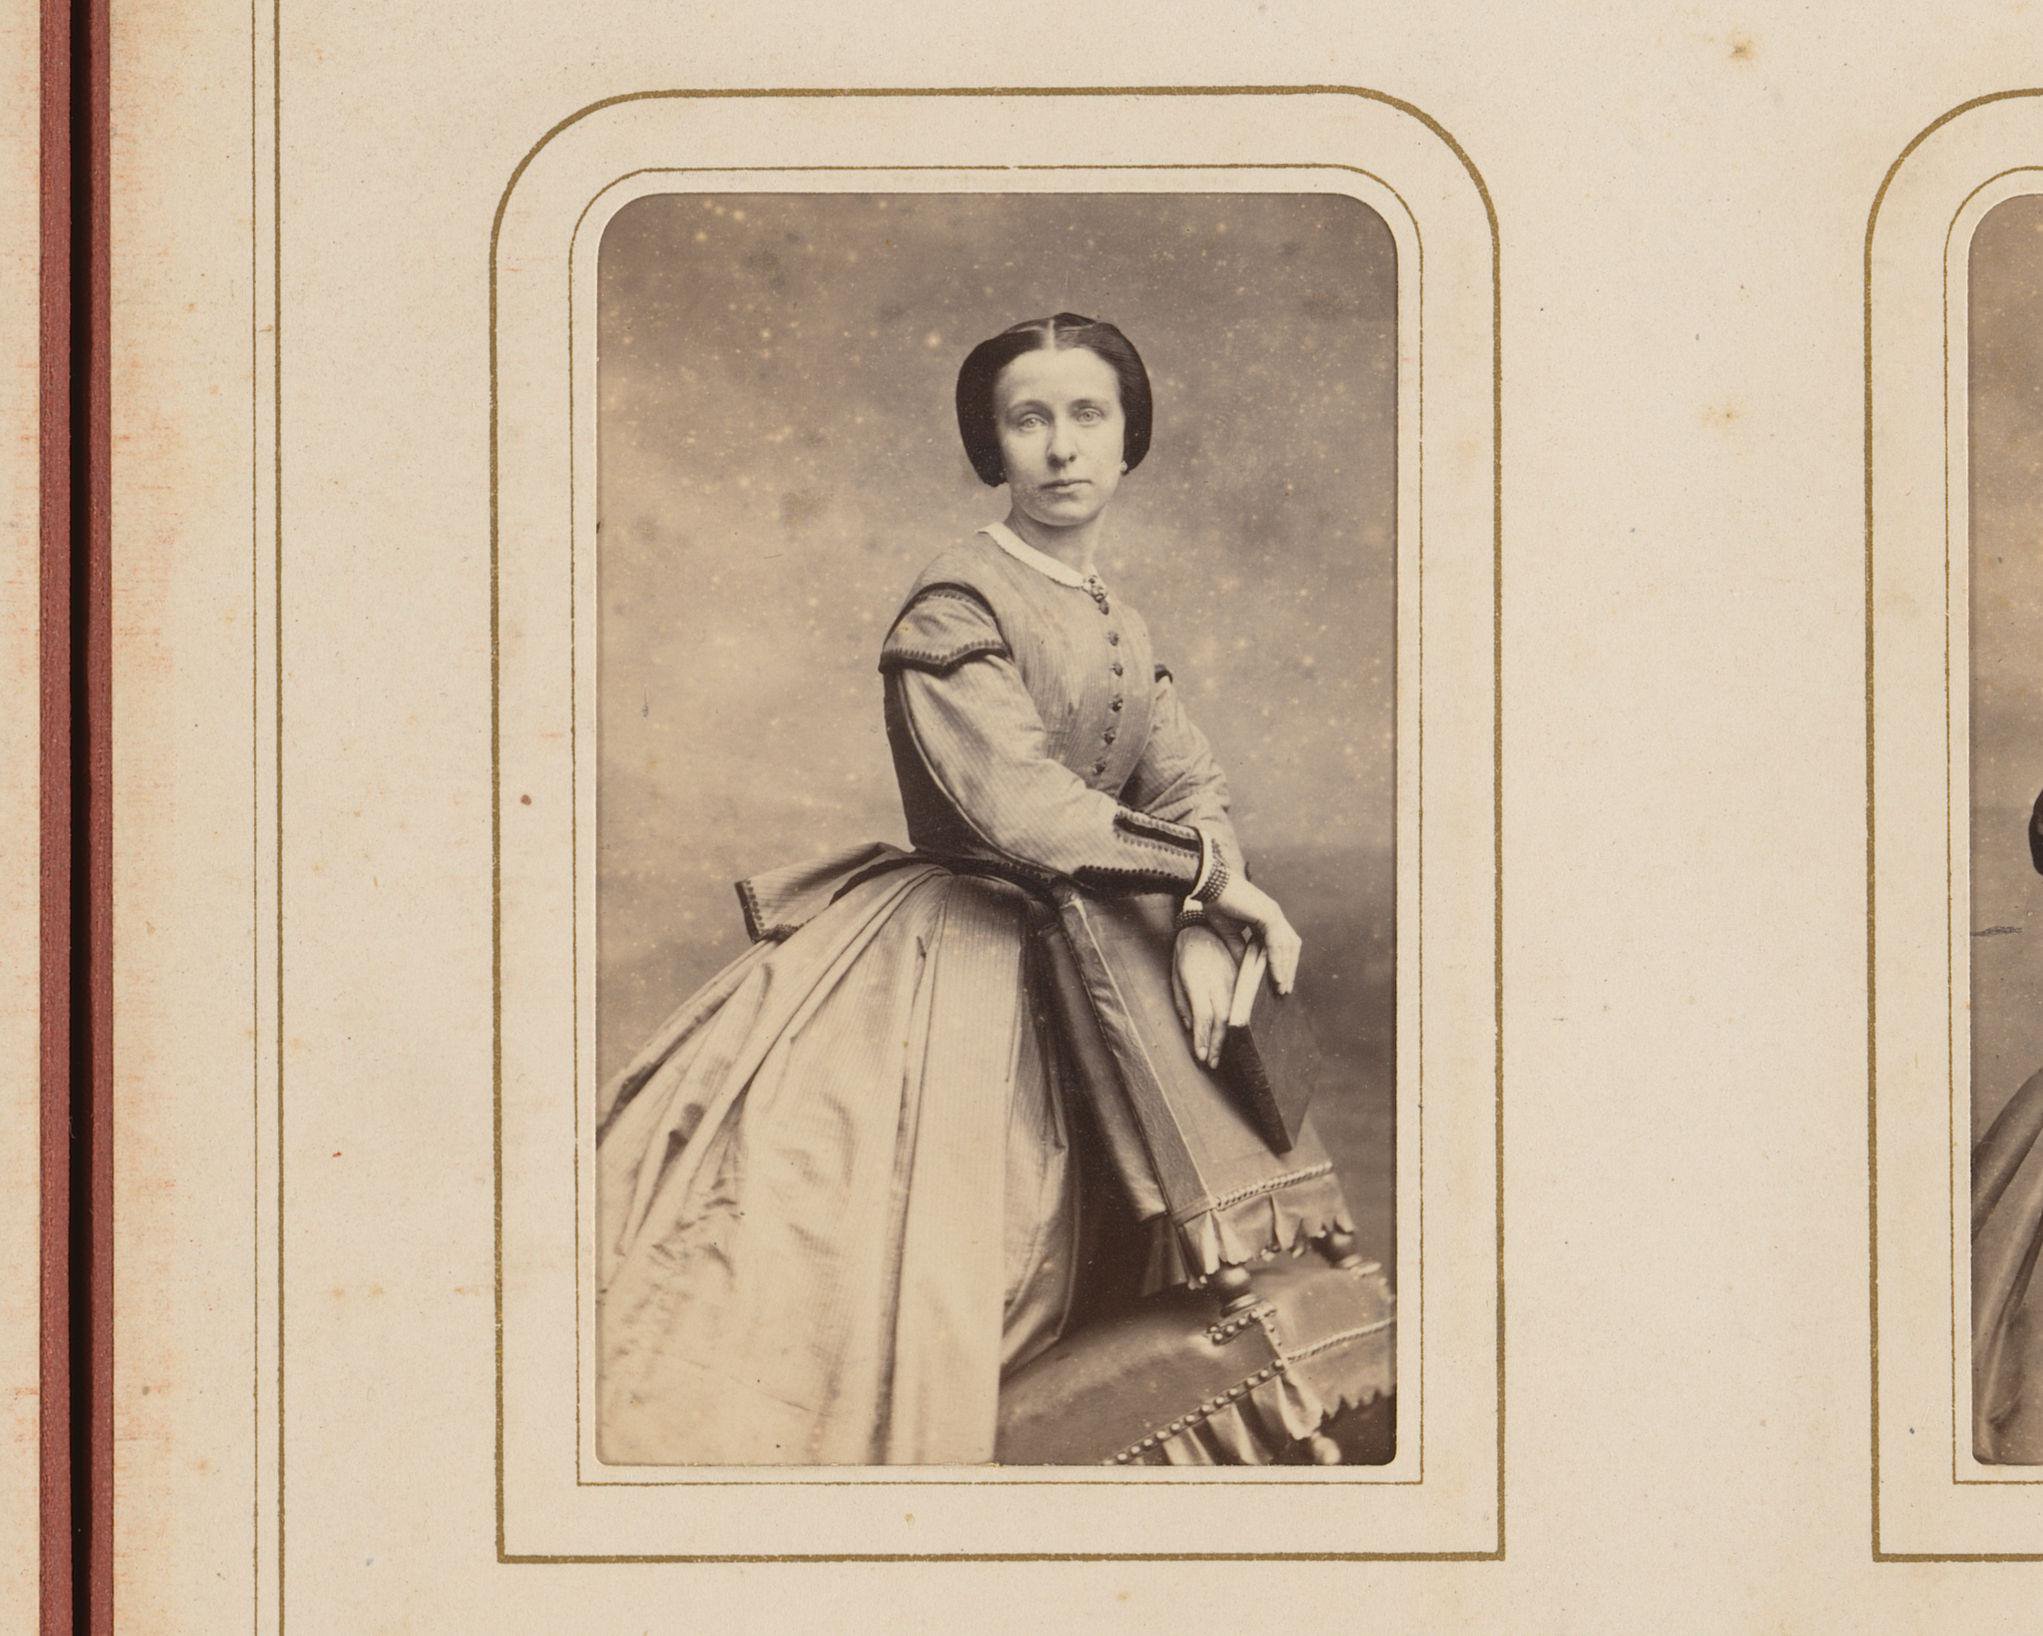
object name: photograph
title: Portret van een vrouw, leunend op een stoel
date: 1862-1900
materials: cardboard, photographic support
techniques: albumen print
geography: amsterdam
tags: historical persons - bb - woman, chair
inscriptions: inscription: ‘PHOTOGr ATELIER/ WEGENER & MOTTU,/ KALVERSTRAAT/ Over den Heyligenweg D. 26/ AMSTERDAM’